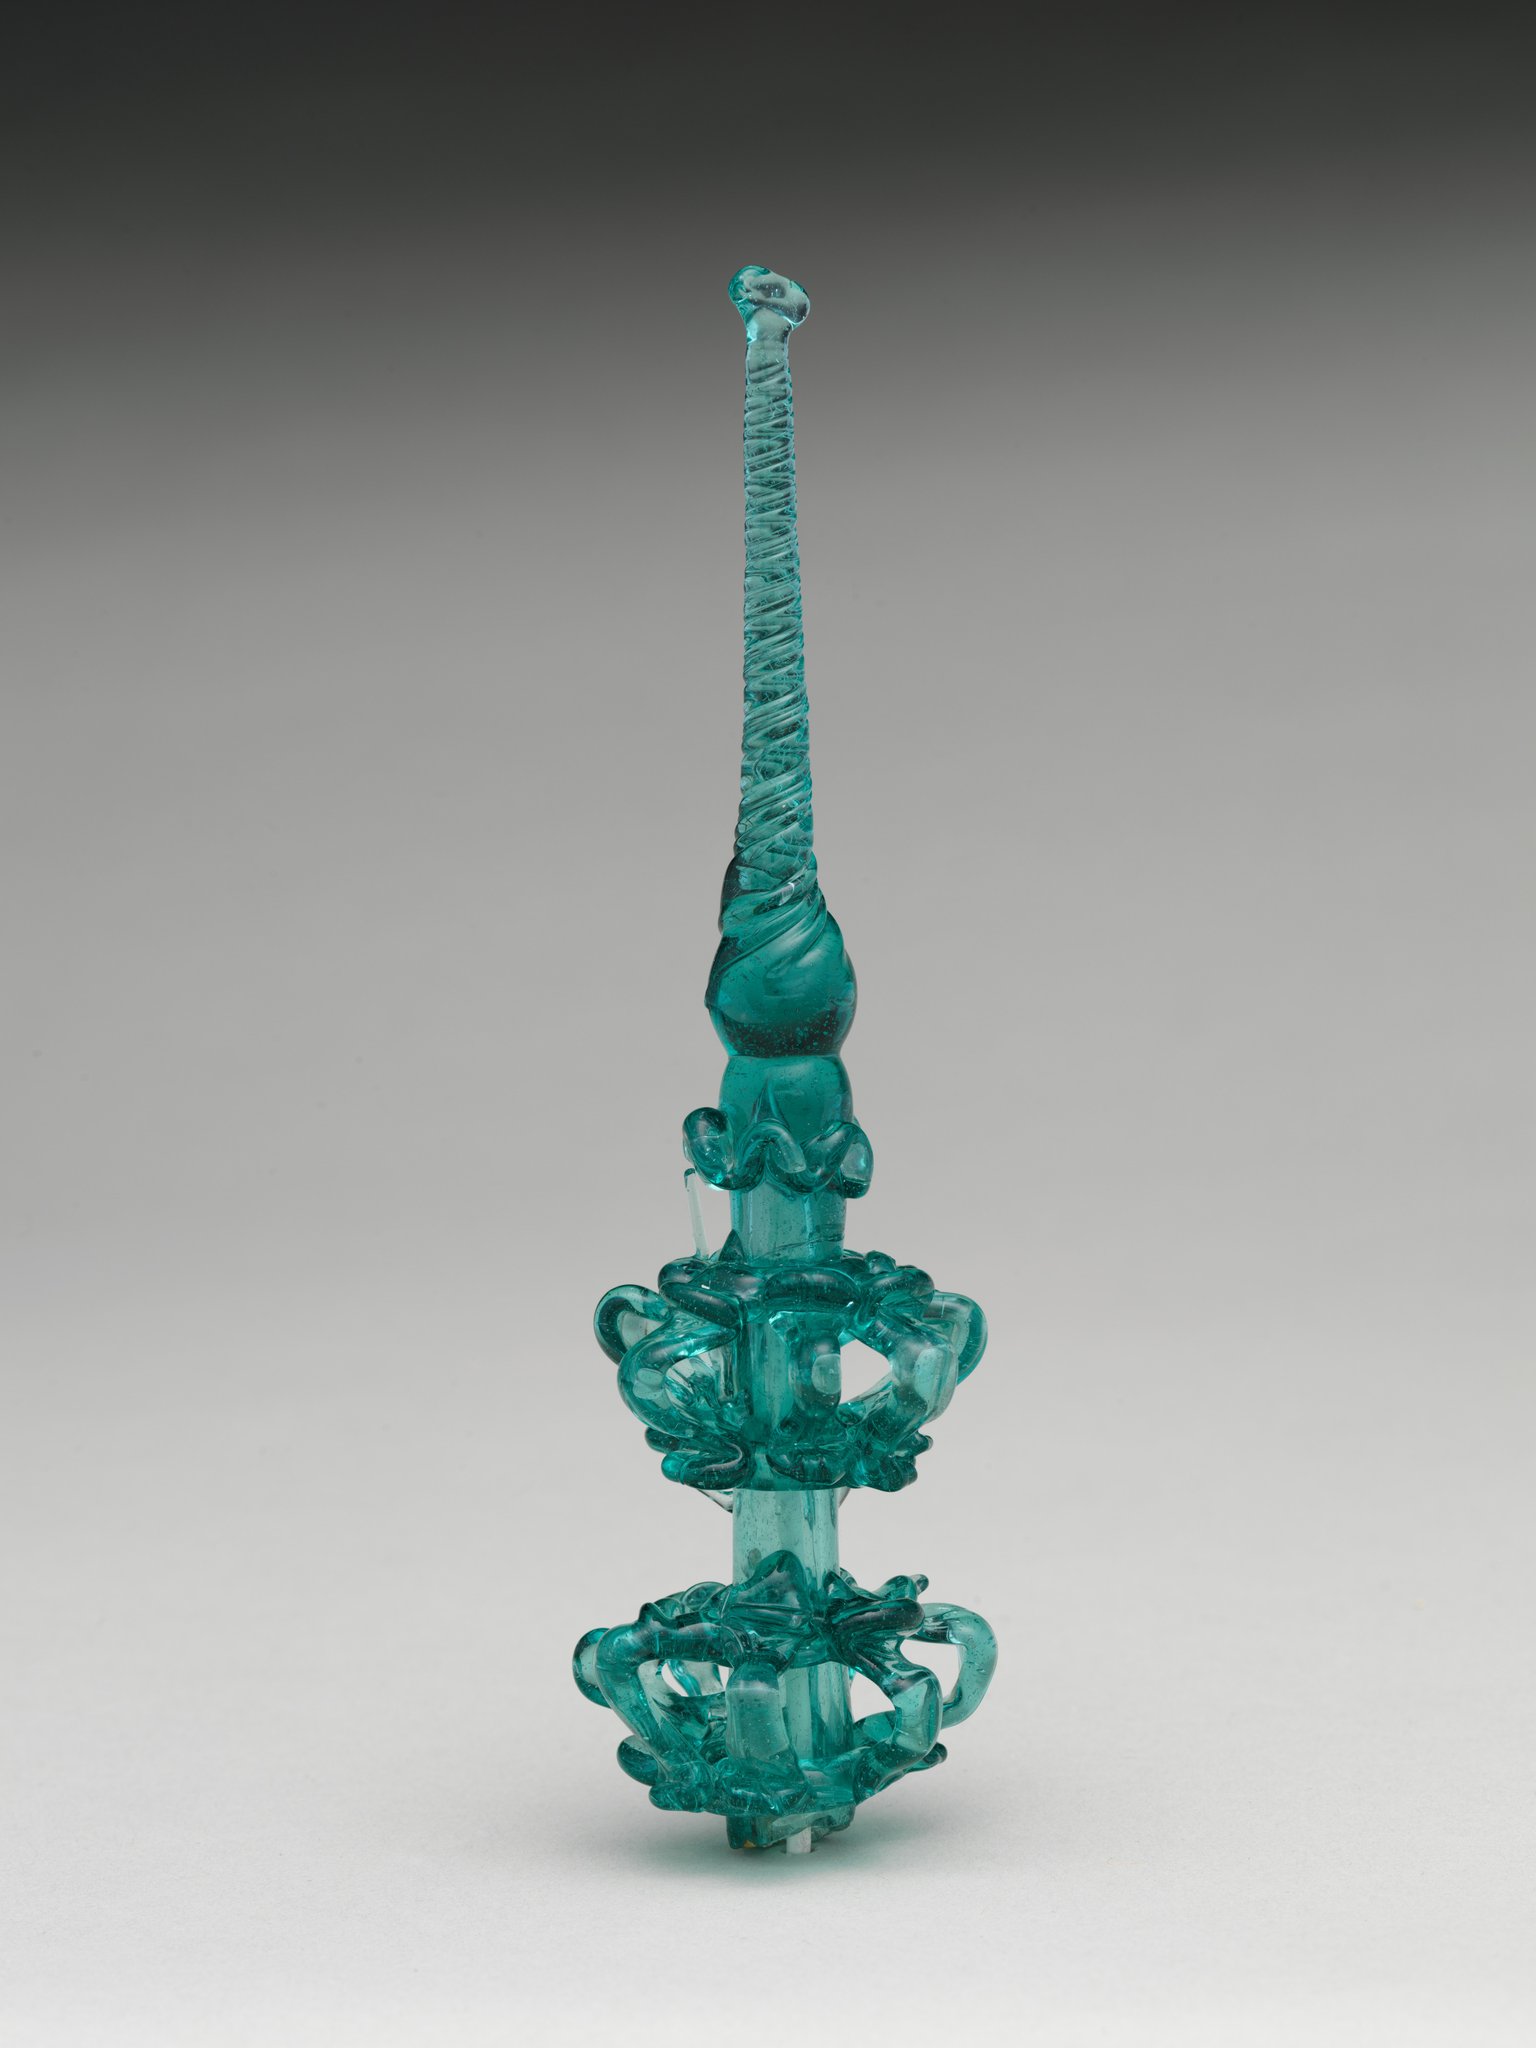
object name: spindle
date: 1701-1800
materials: glass